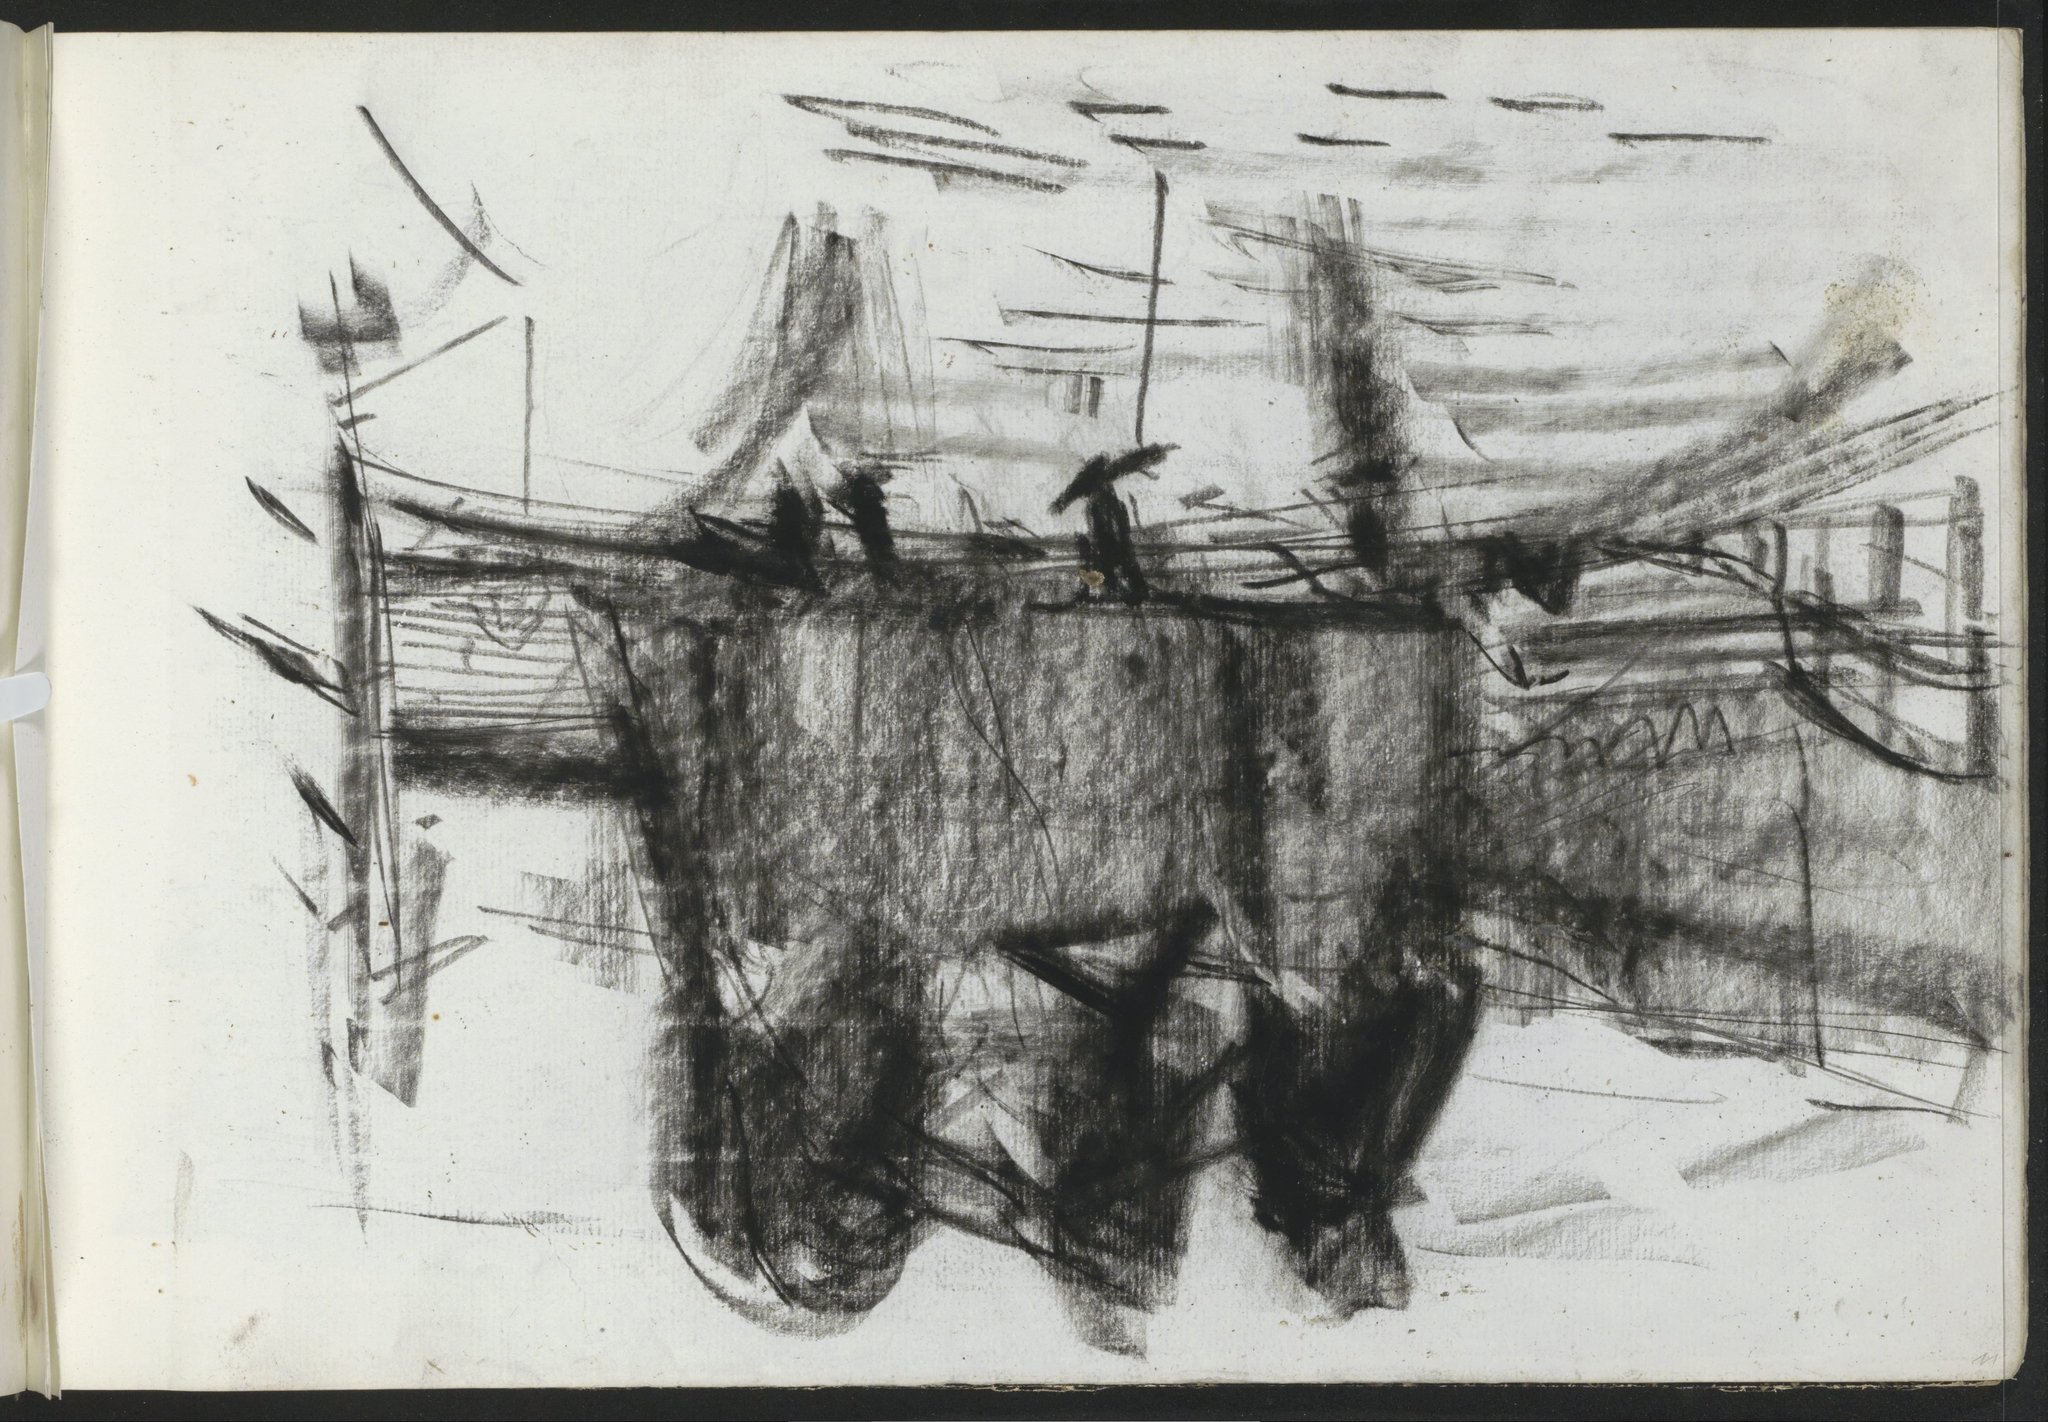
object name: sketchbook leaf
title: Drie vrouwen op straat in Amsterdam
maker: isaac israels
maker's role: draughtsman, painter, print maker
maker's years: 1865-1934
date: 1886-1934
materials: chalk, paper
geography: amsterdam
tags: adult woman (+ three persons), street (+ city(-scape) with figures, staffage), amsterdam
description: Mogelijk op een brug. Blad 11 recto uit schetsboek LXX met 17 bladen.